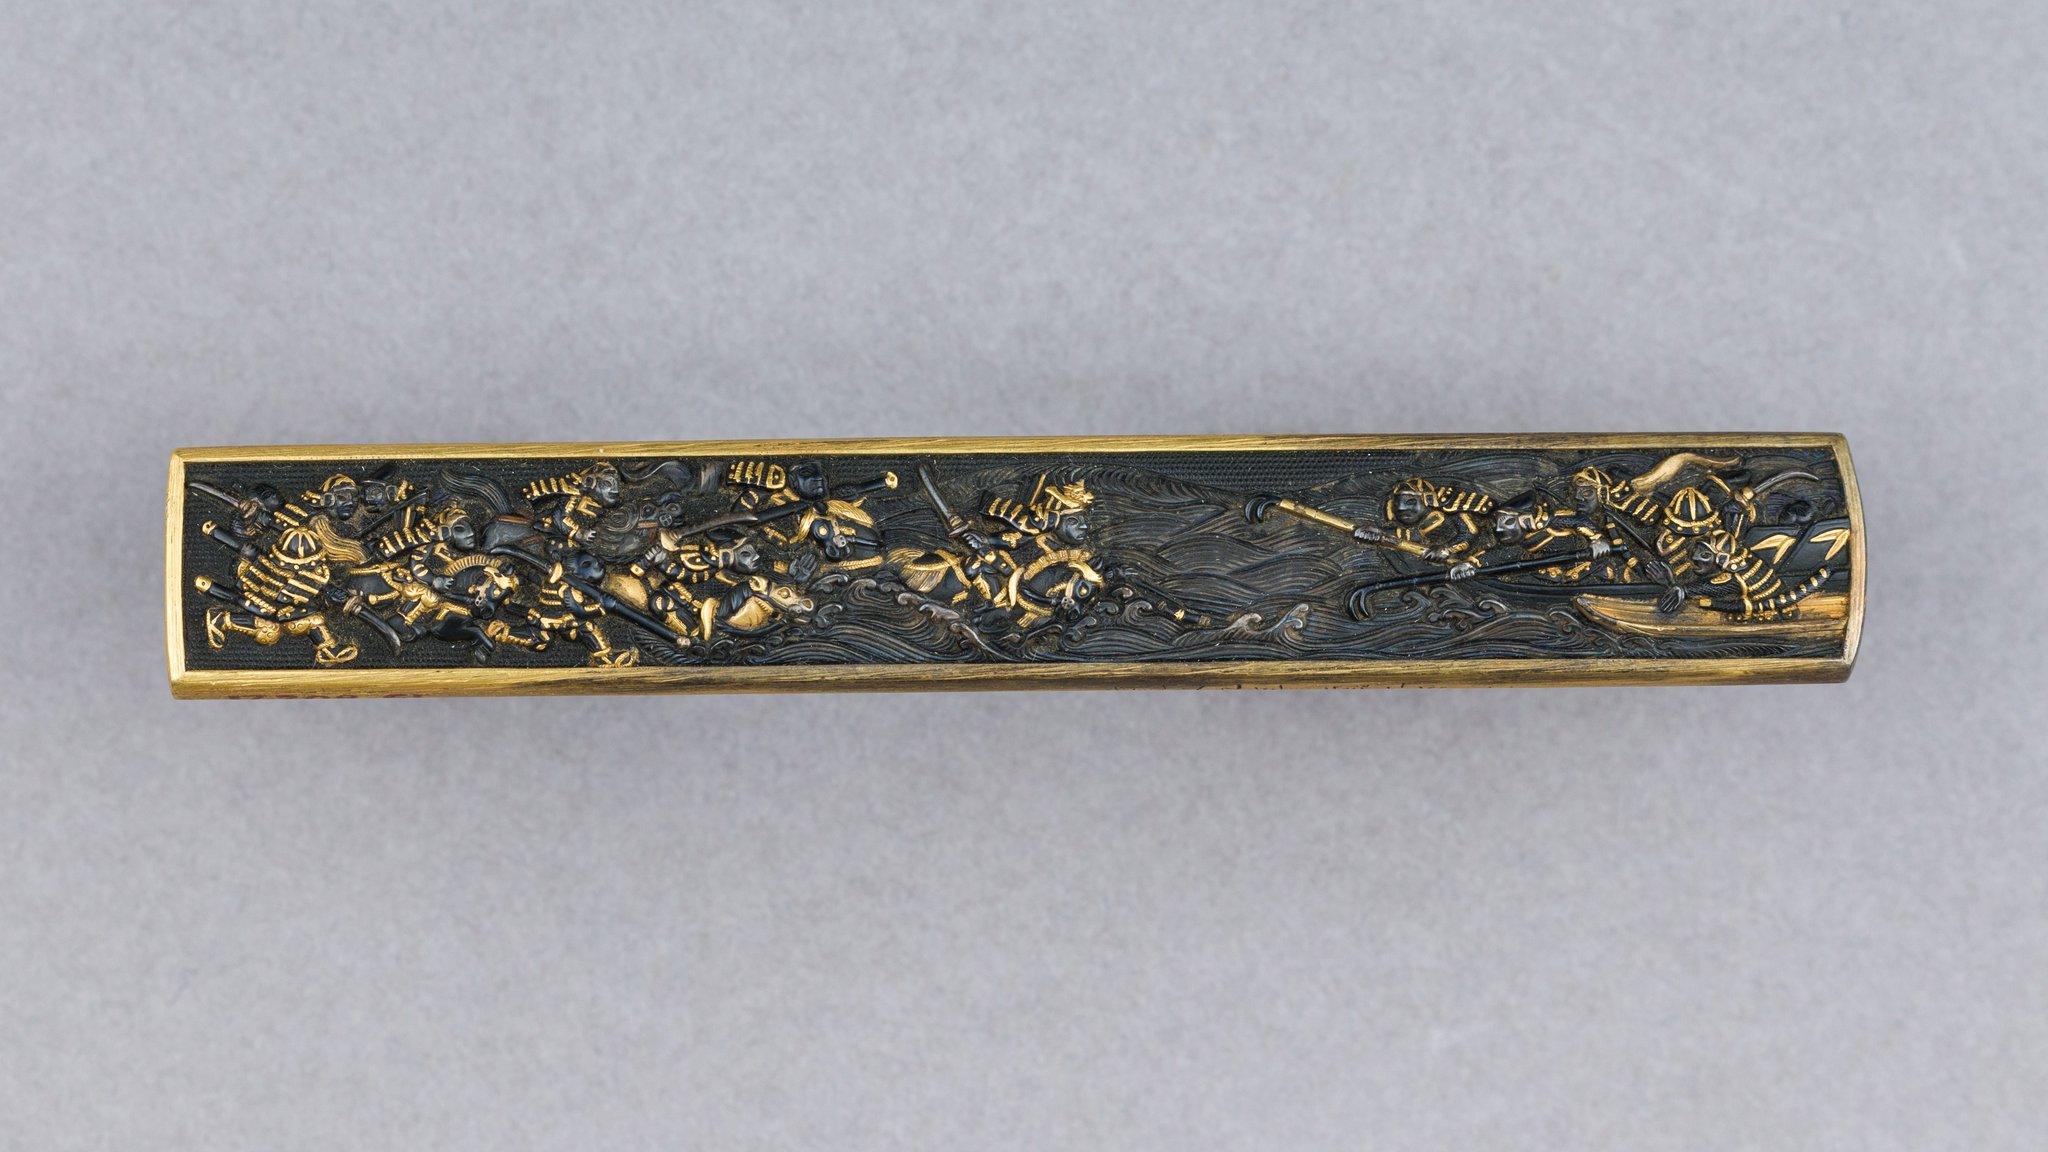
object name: knife handle kozuka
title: Knife Handle (Kozuka)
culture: japanese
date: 1601-1700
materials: gold alloy, silver alloy, gold, silver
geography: japan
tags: battles,men